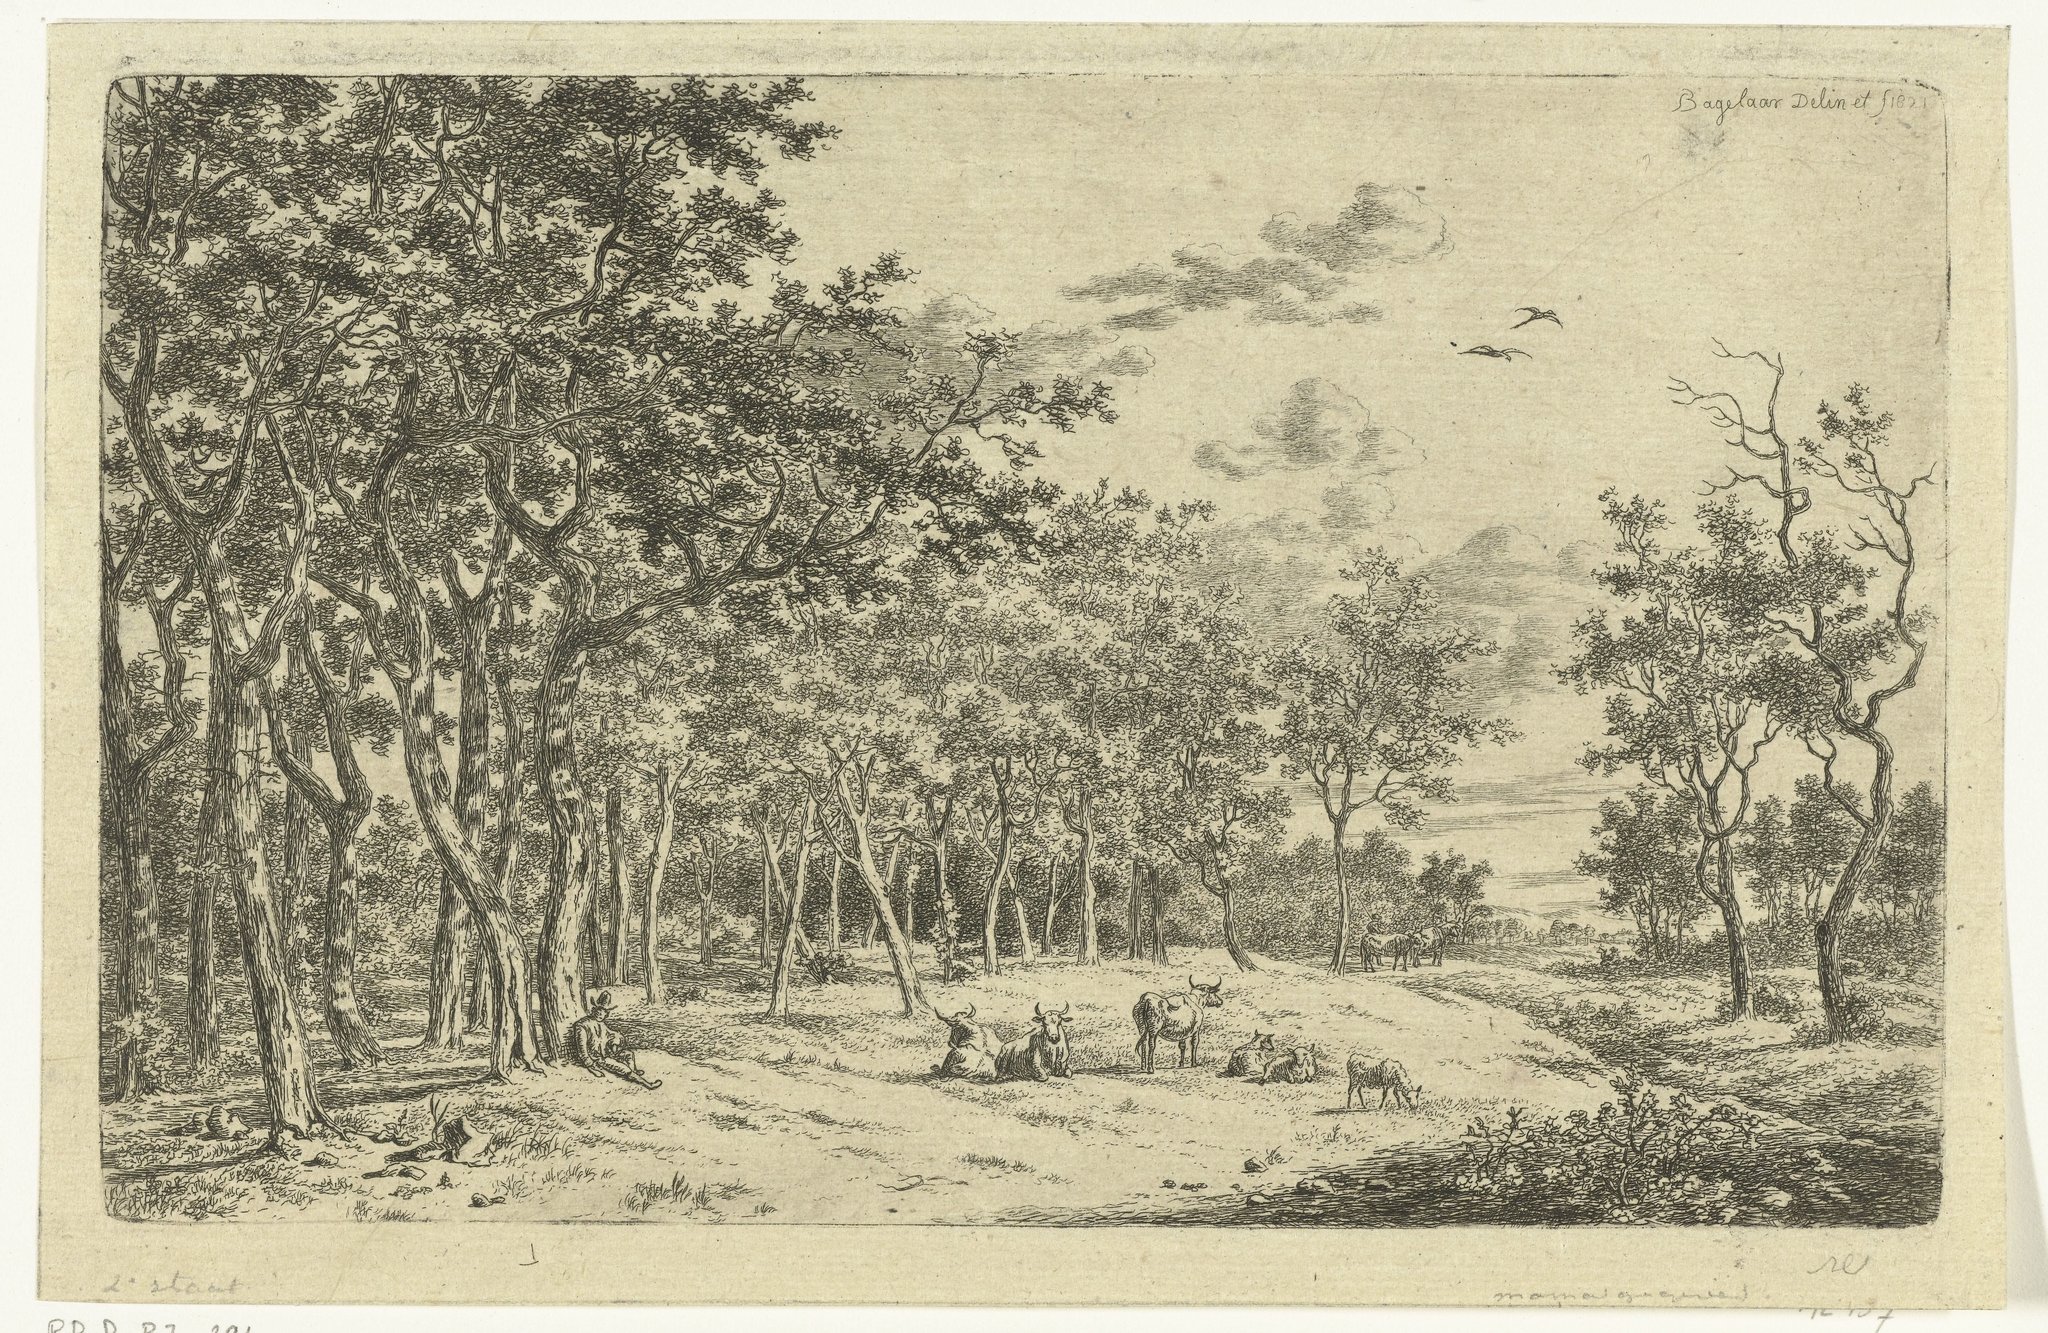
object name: print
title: Landschap met een herder en zijn kudde aan de rand van het bos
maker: ernst willem jan bagelaar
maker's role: draughtsman, print maker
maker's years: 1775-1837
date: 1821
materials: paper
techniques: drypoint, etching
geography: netherlands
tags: herding, herdsman, herdswoman, shepherd, shepherdess, cowherd, etc.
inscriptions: collector's mark: Lugt 2228